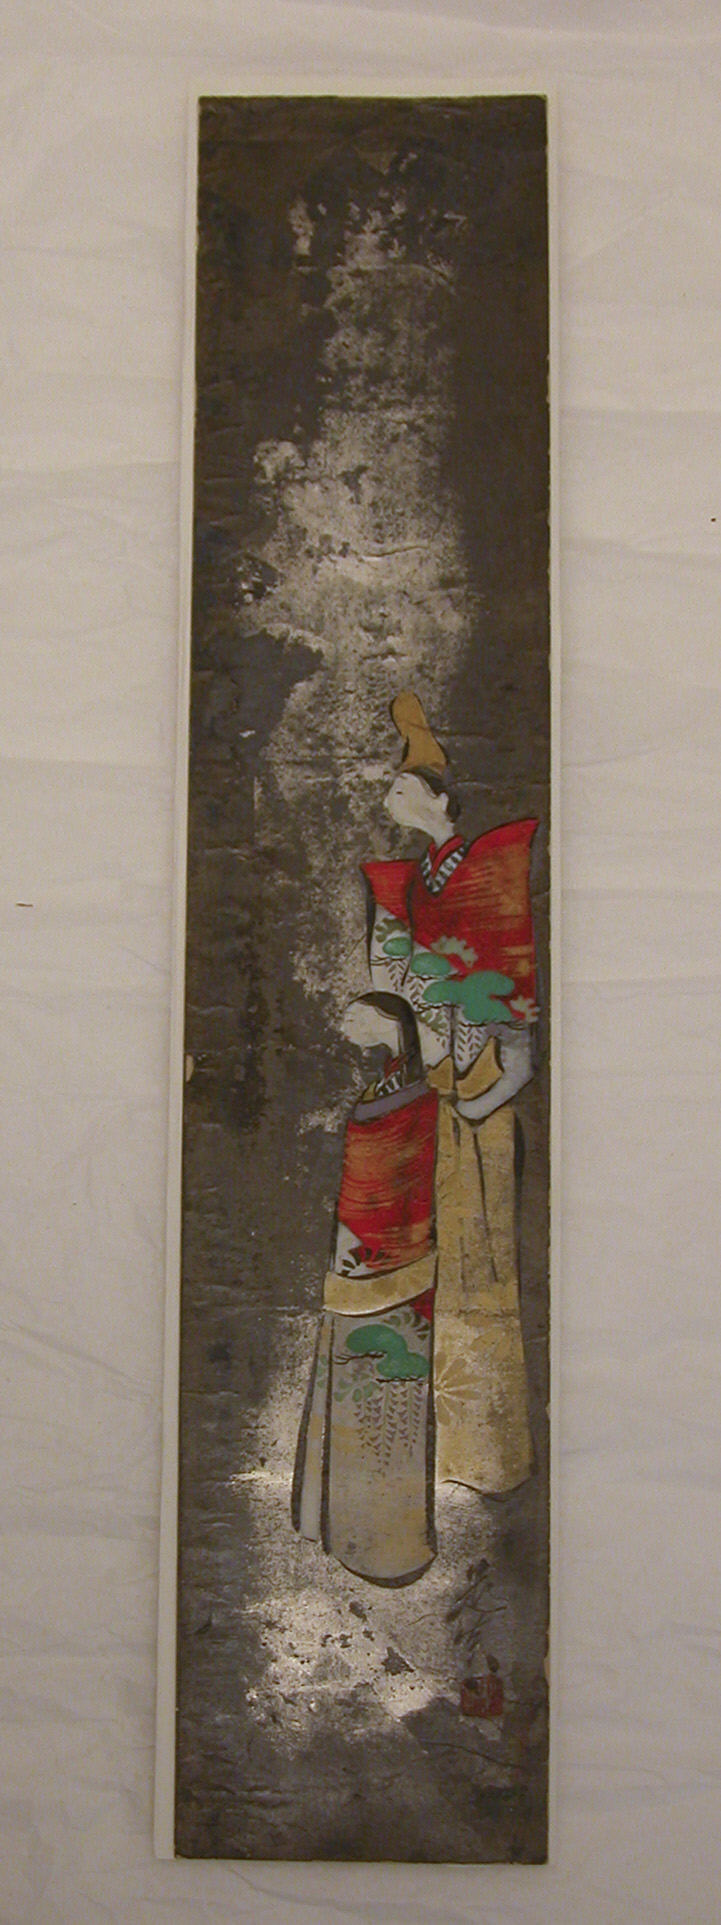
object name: painting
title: Dolls (Tate-bina)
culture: japanese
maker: shibata zeshin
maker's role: artist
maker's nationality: japanese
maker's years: 1807-1891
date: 1801-1900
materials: ink, paper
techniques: painting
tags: dolls